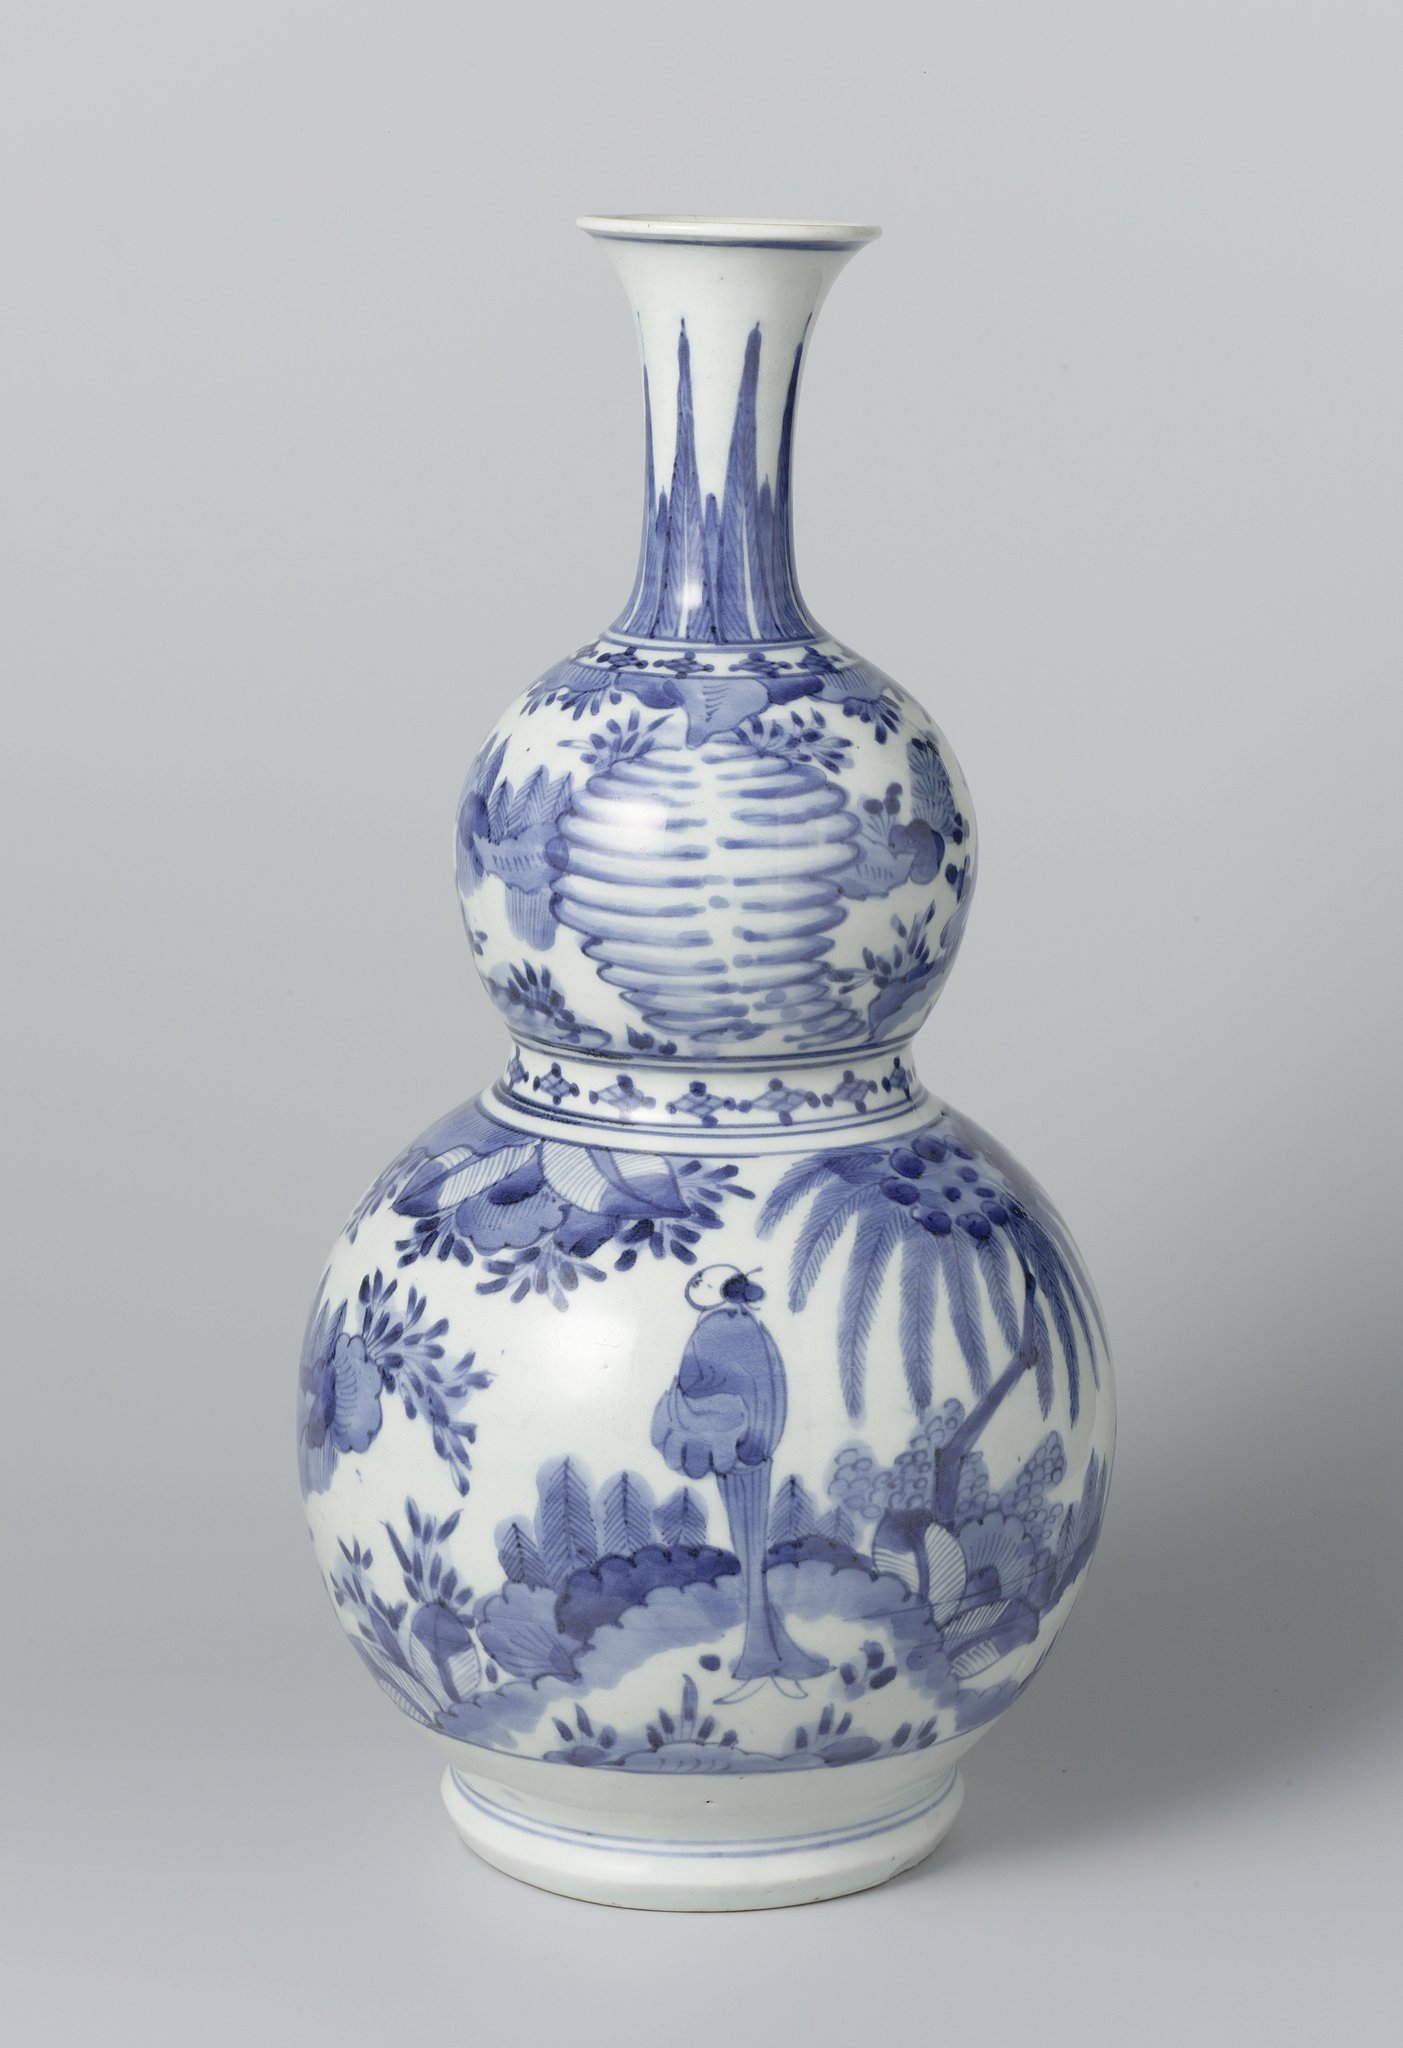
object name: vase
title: Gourd-shaped vase with two figures in a landscape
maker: Anonymous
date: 1660-1680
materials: cobalt, glaze, paint, porcelain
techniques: firing, turning, vitrification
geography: japan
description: Chinese and Japanese porcelain decorated in underglaze blue. Vase. China, 1635-1645. Vase. Japan, 1660-1680. Ewer. China, 1635-1640.